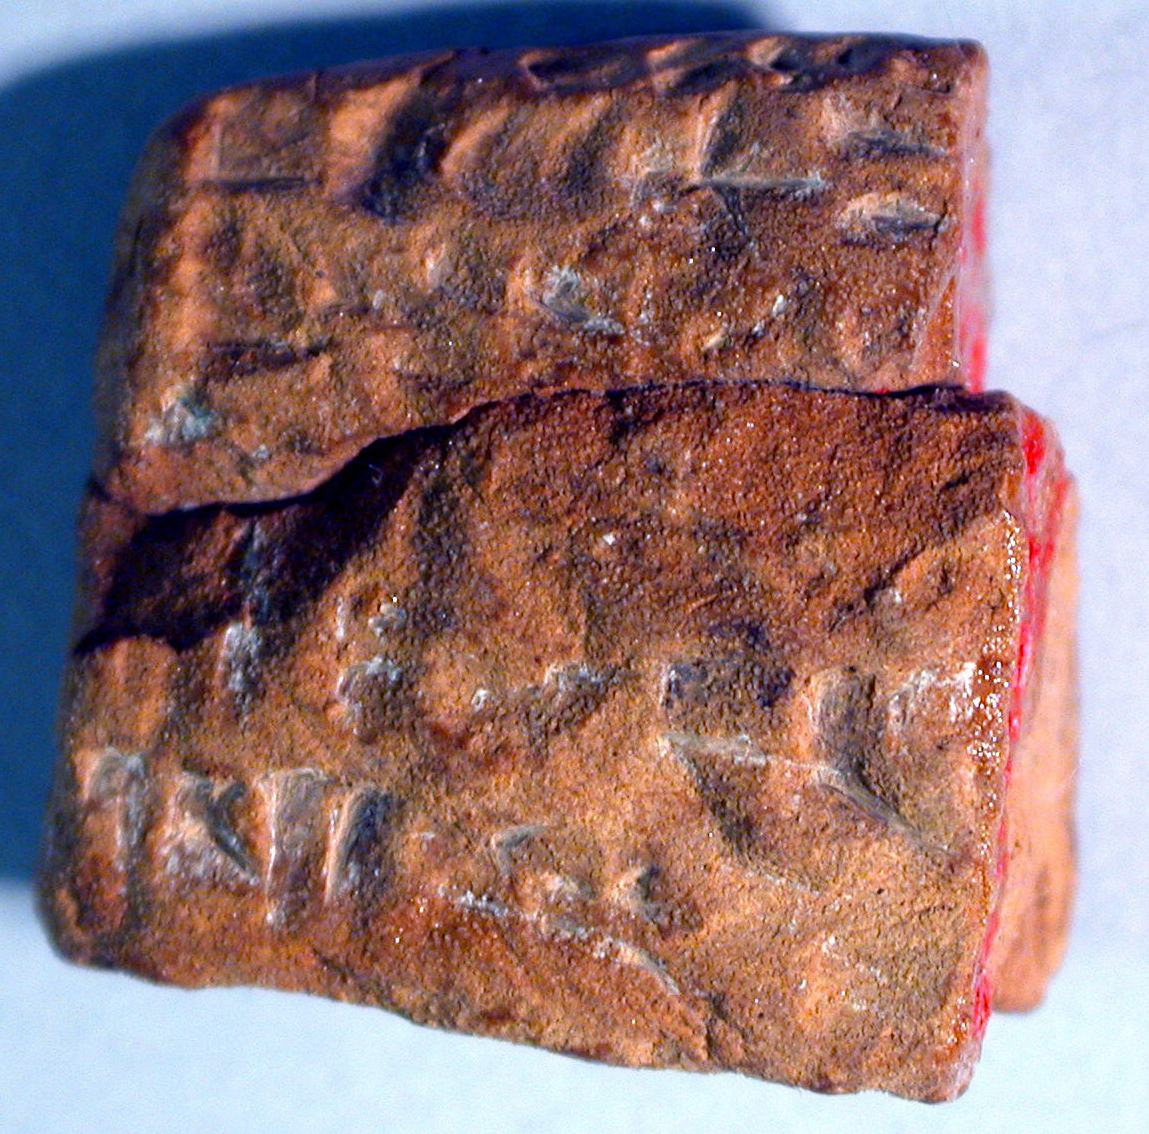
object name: cuneiform tablet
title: Cuneiform tablet: fragment of a lease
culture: achaemenid or babylonian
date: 700-301 BCE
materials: clay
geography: mesopotamia